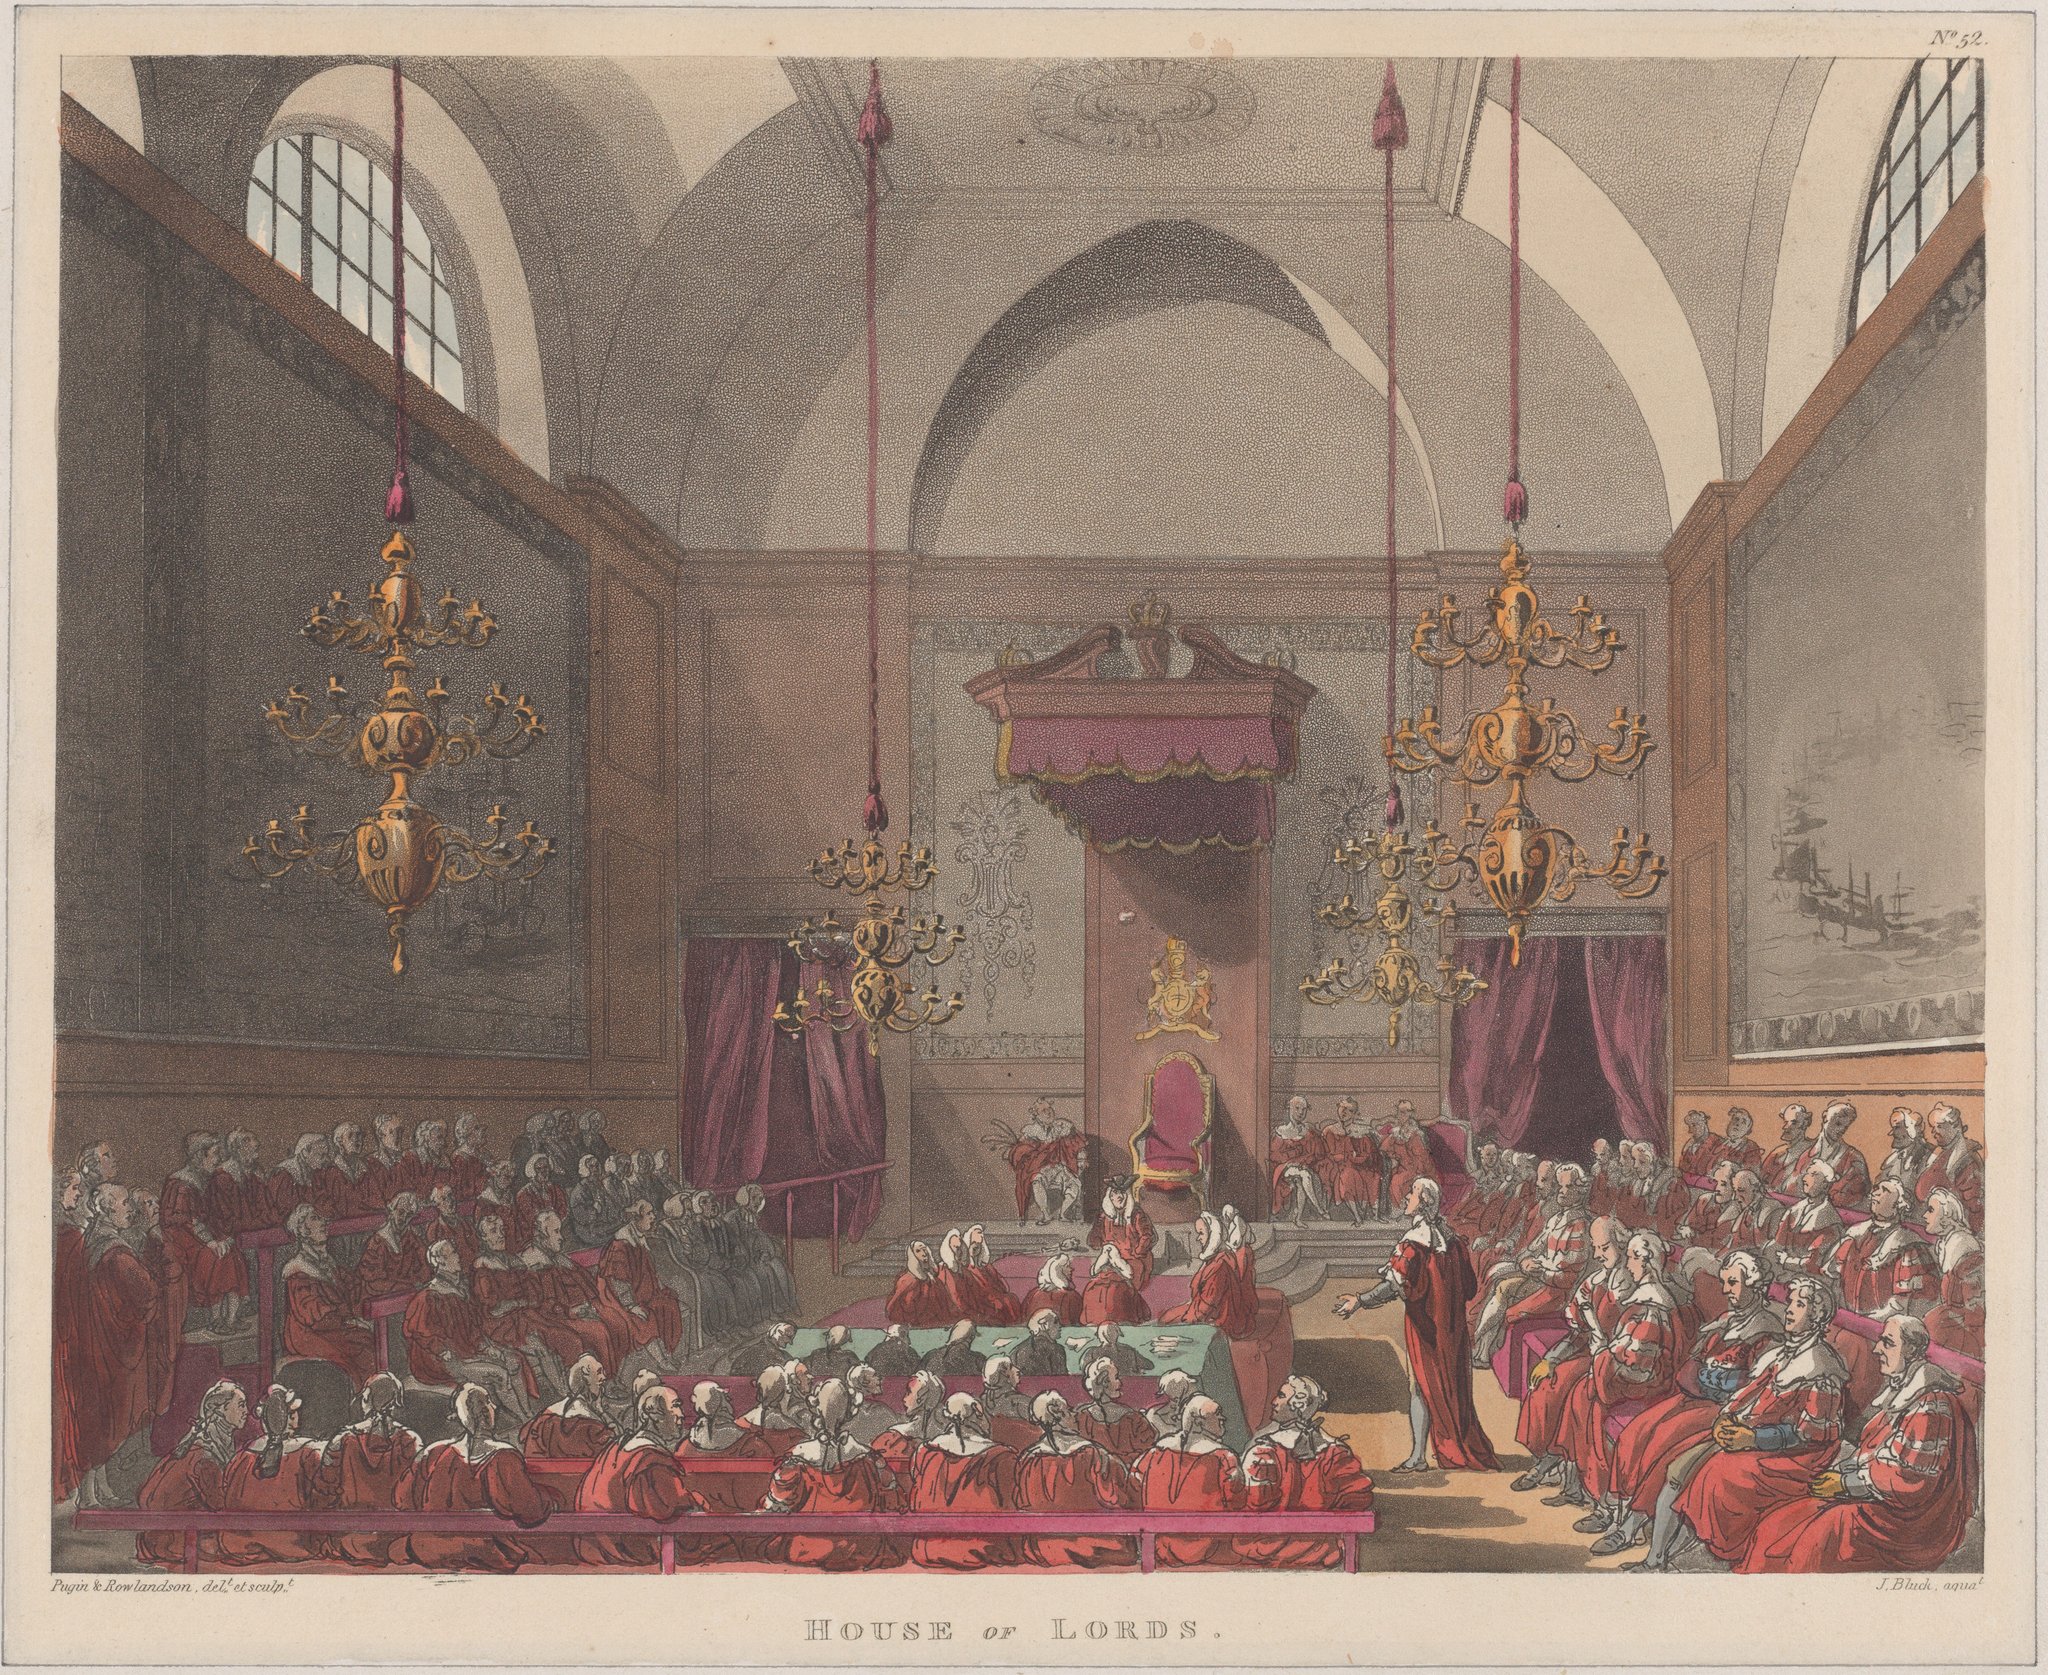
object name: print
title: House of Lords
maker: thomas rowlandson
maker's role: artist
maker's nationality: british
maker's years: 1757-1827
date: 1808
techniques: aquatint, etching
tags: government,interiors